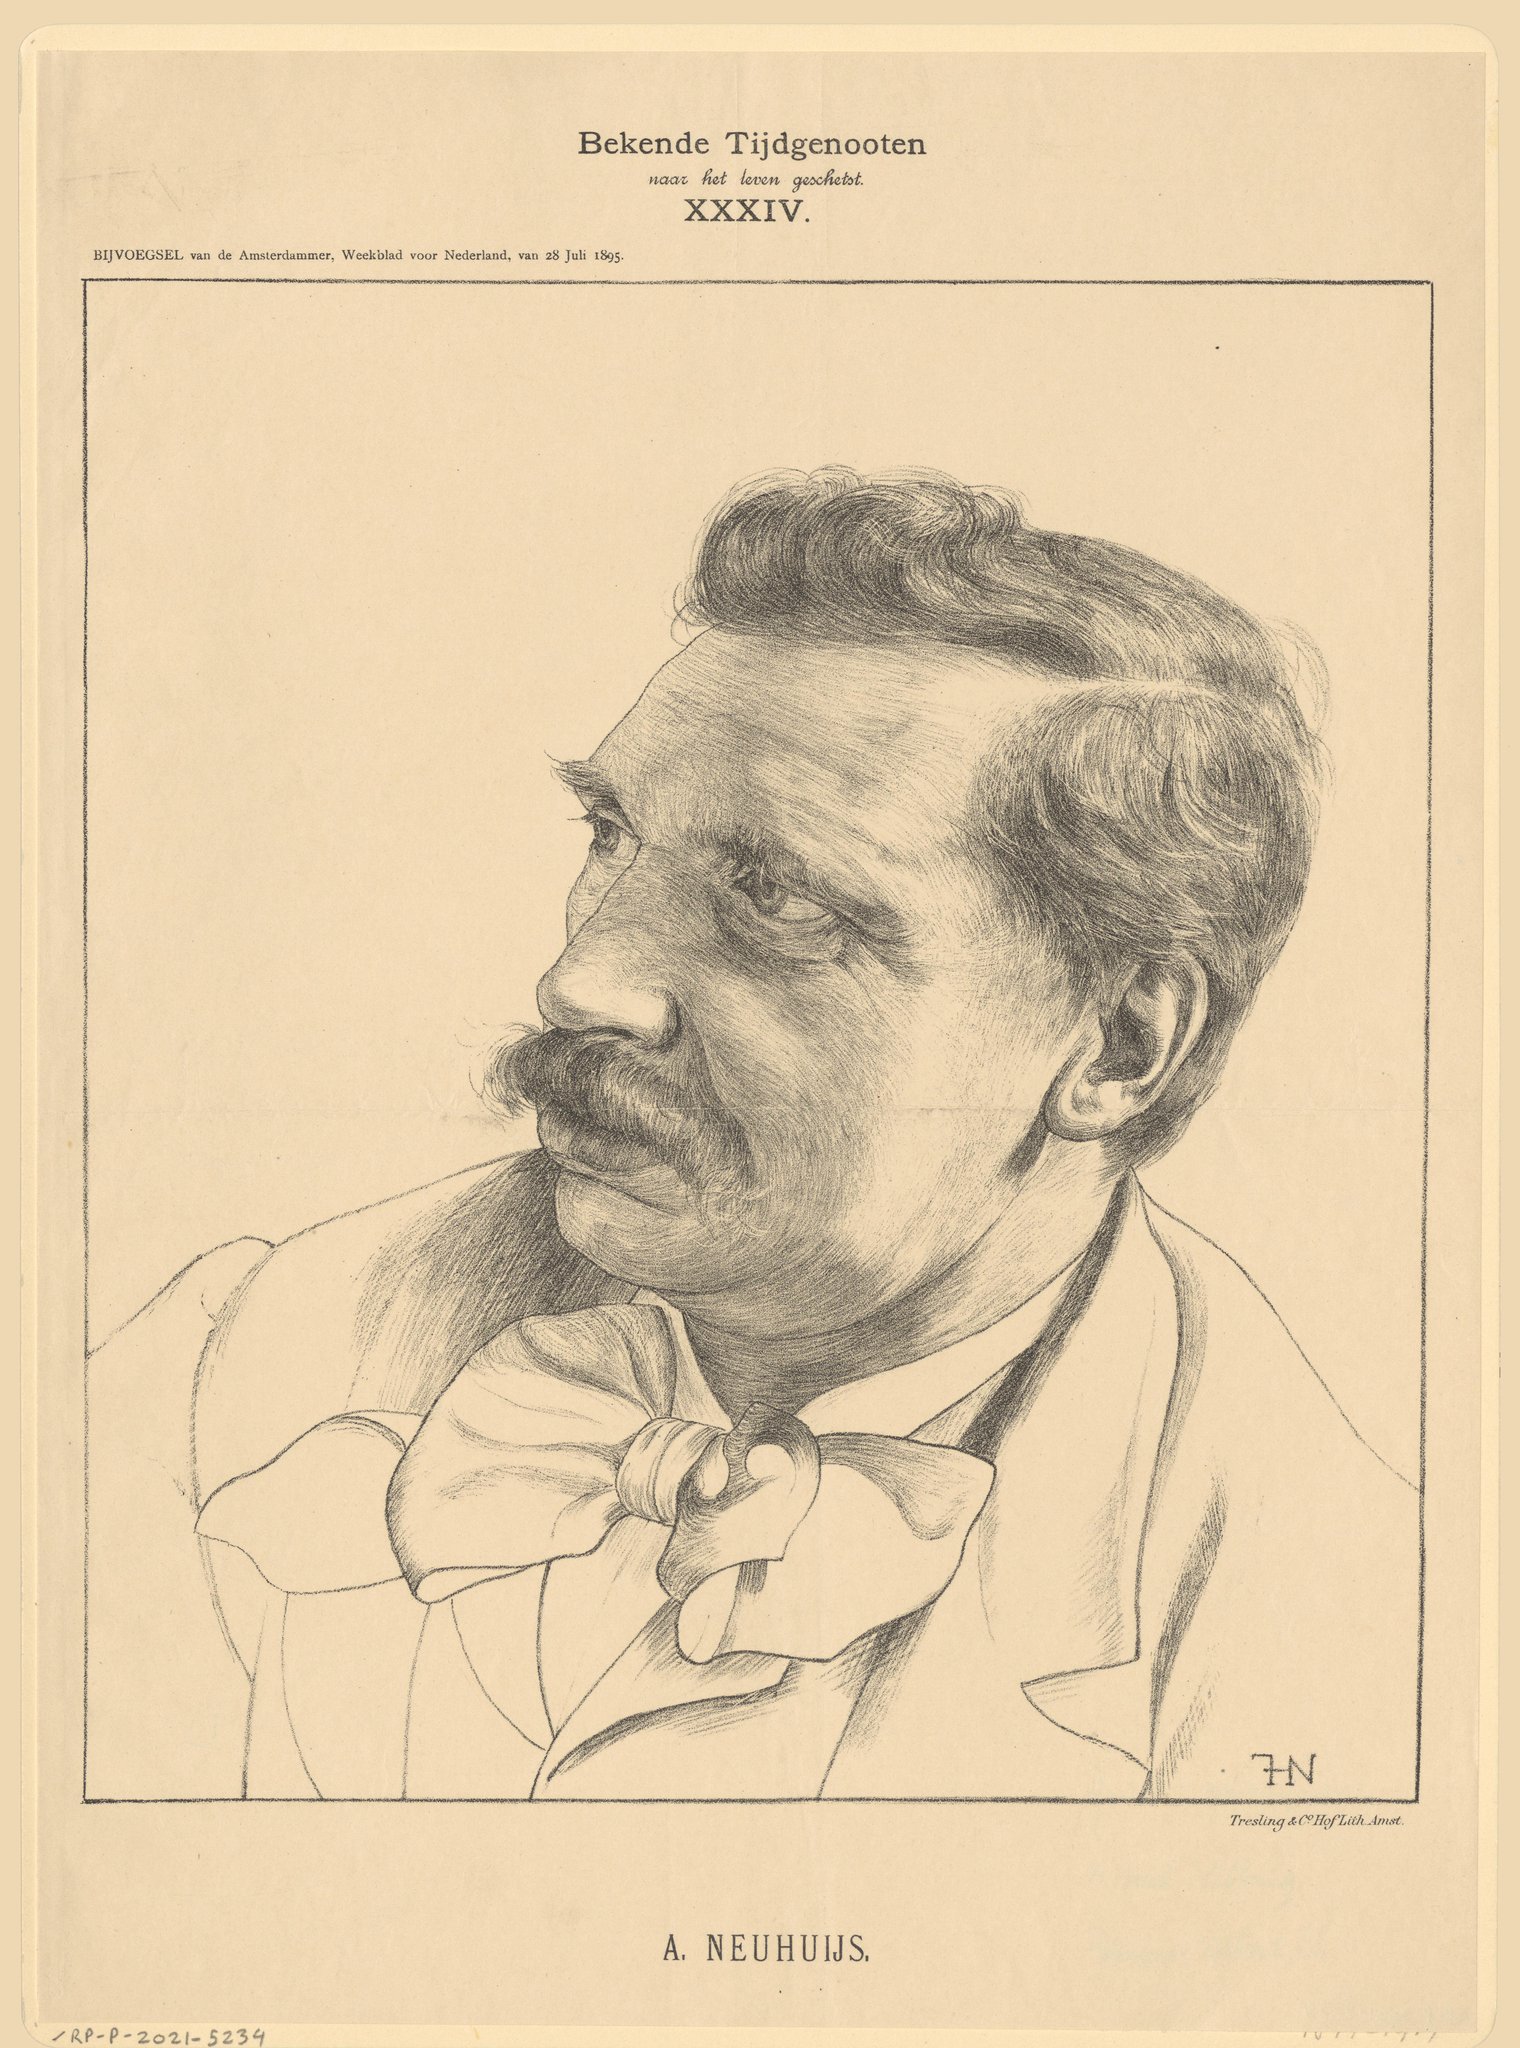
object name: print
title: Portret van Albert Neuhuys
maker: ferdinand hart nibbrig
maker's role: draughtsman, painter, print maker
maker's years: 1866-1915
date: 1895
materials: paper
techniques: lithograph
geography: amsterdam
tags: utrecht, print maker, draughtsman, albert neuhuys (1844-1914), historical persons, portrait, self-portrait of artist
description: Prent is verschenen als bijvoegsel van: De Amsterdammer. Weekblad voor Nederland (1895), nr. 944, 28 juli 1895.